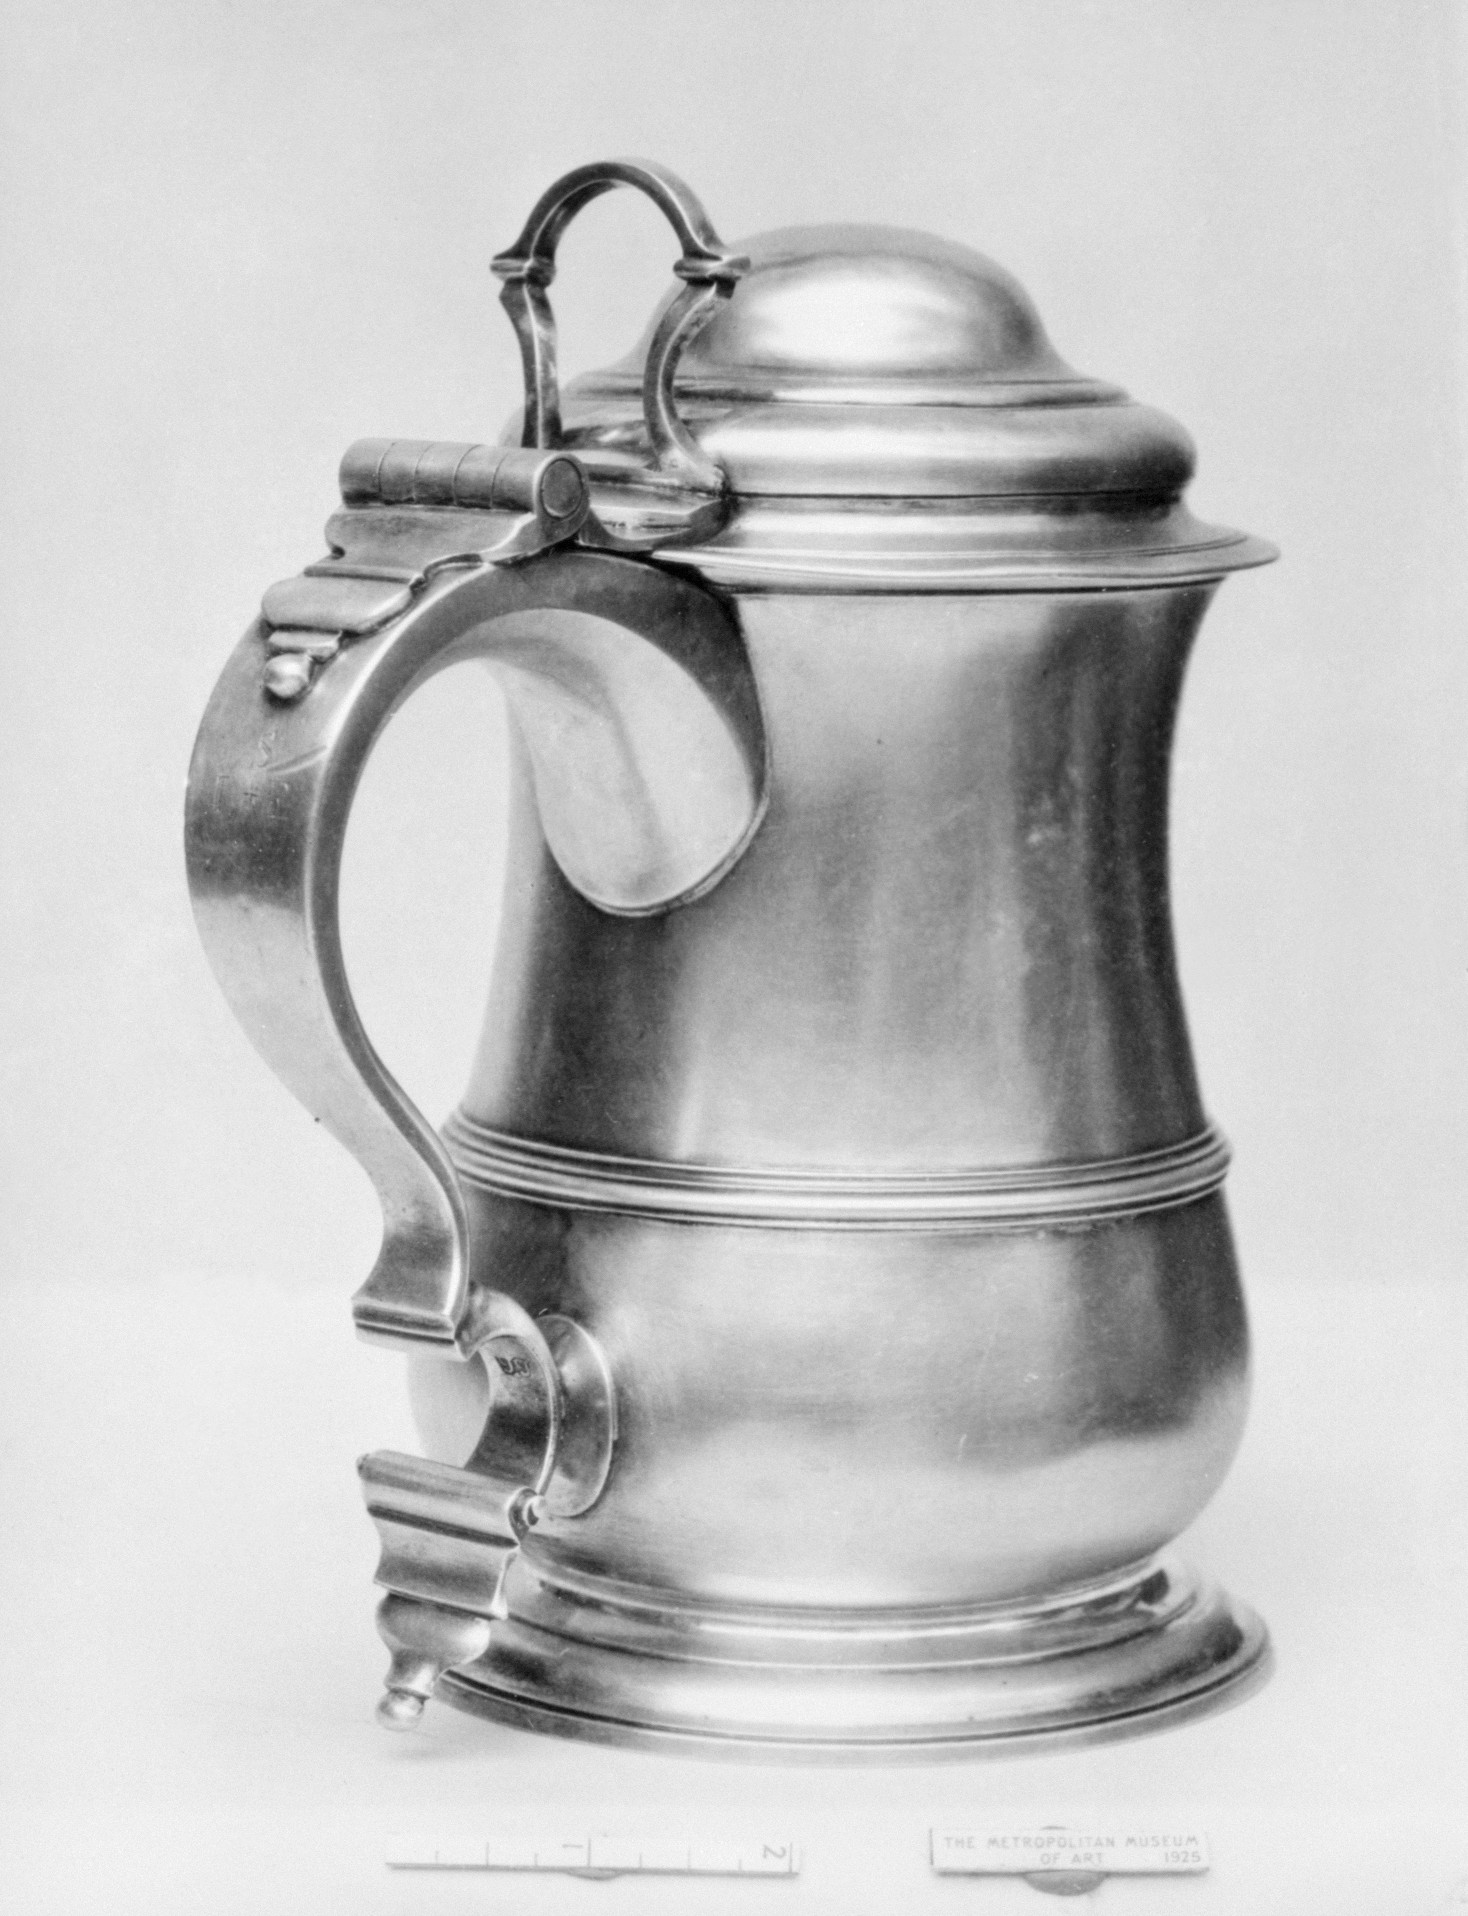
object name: tankard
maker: thomas farren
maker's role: maker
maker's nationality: british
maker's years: 1703-1743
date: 1742-1743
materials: silver